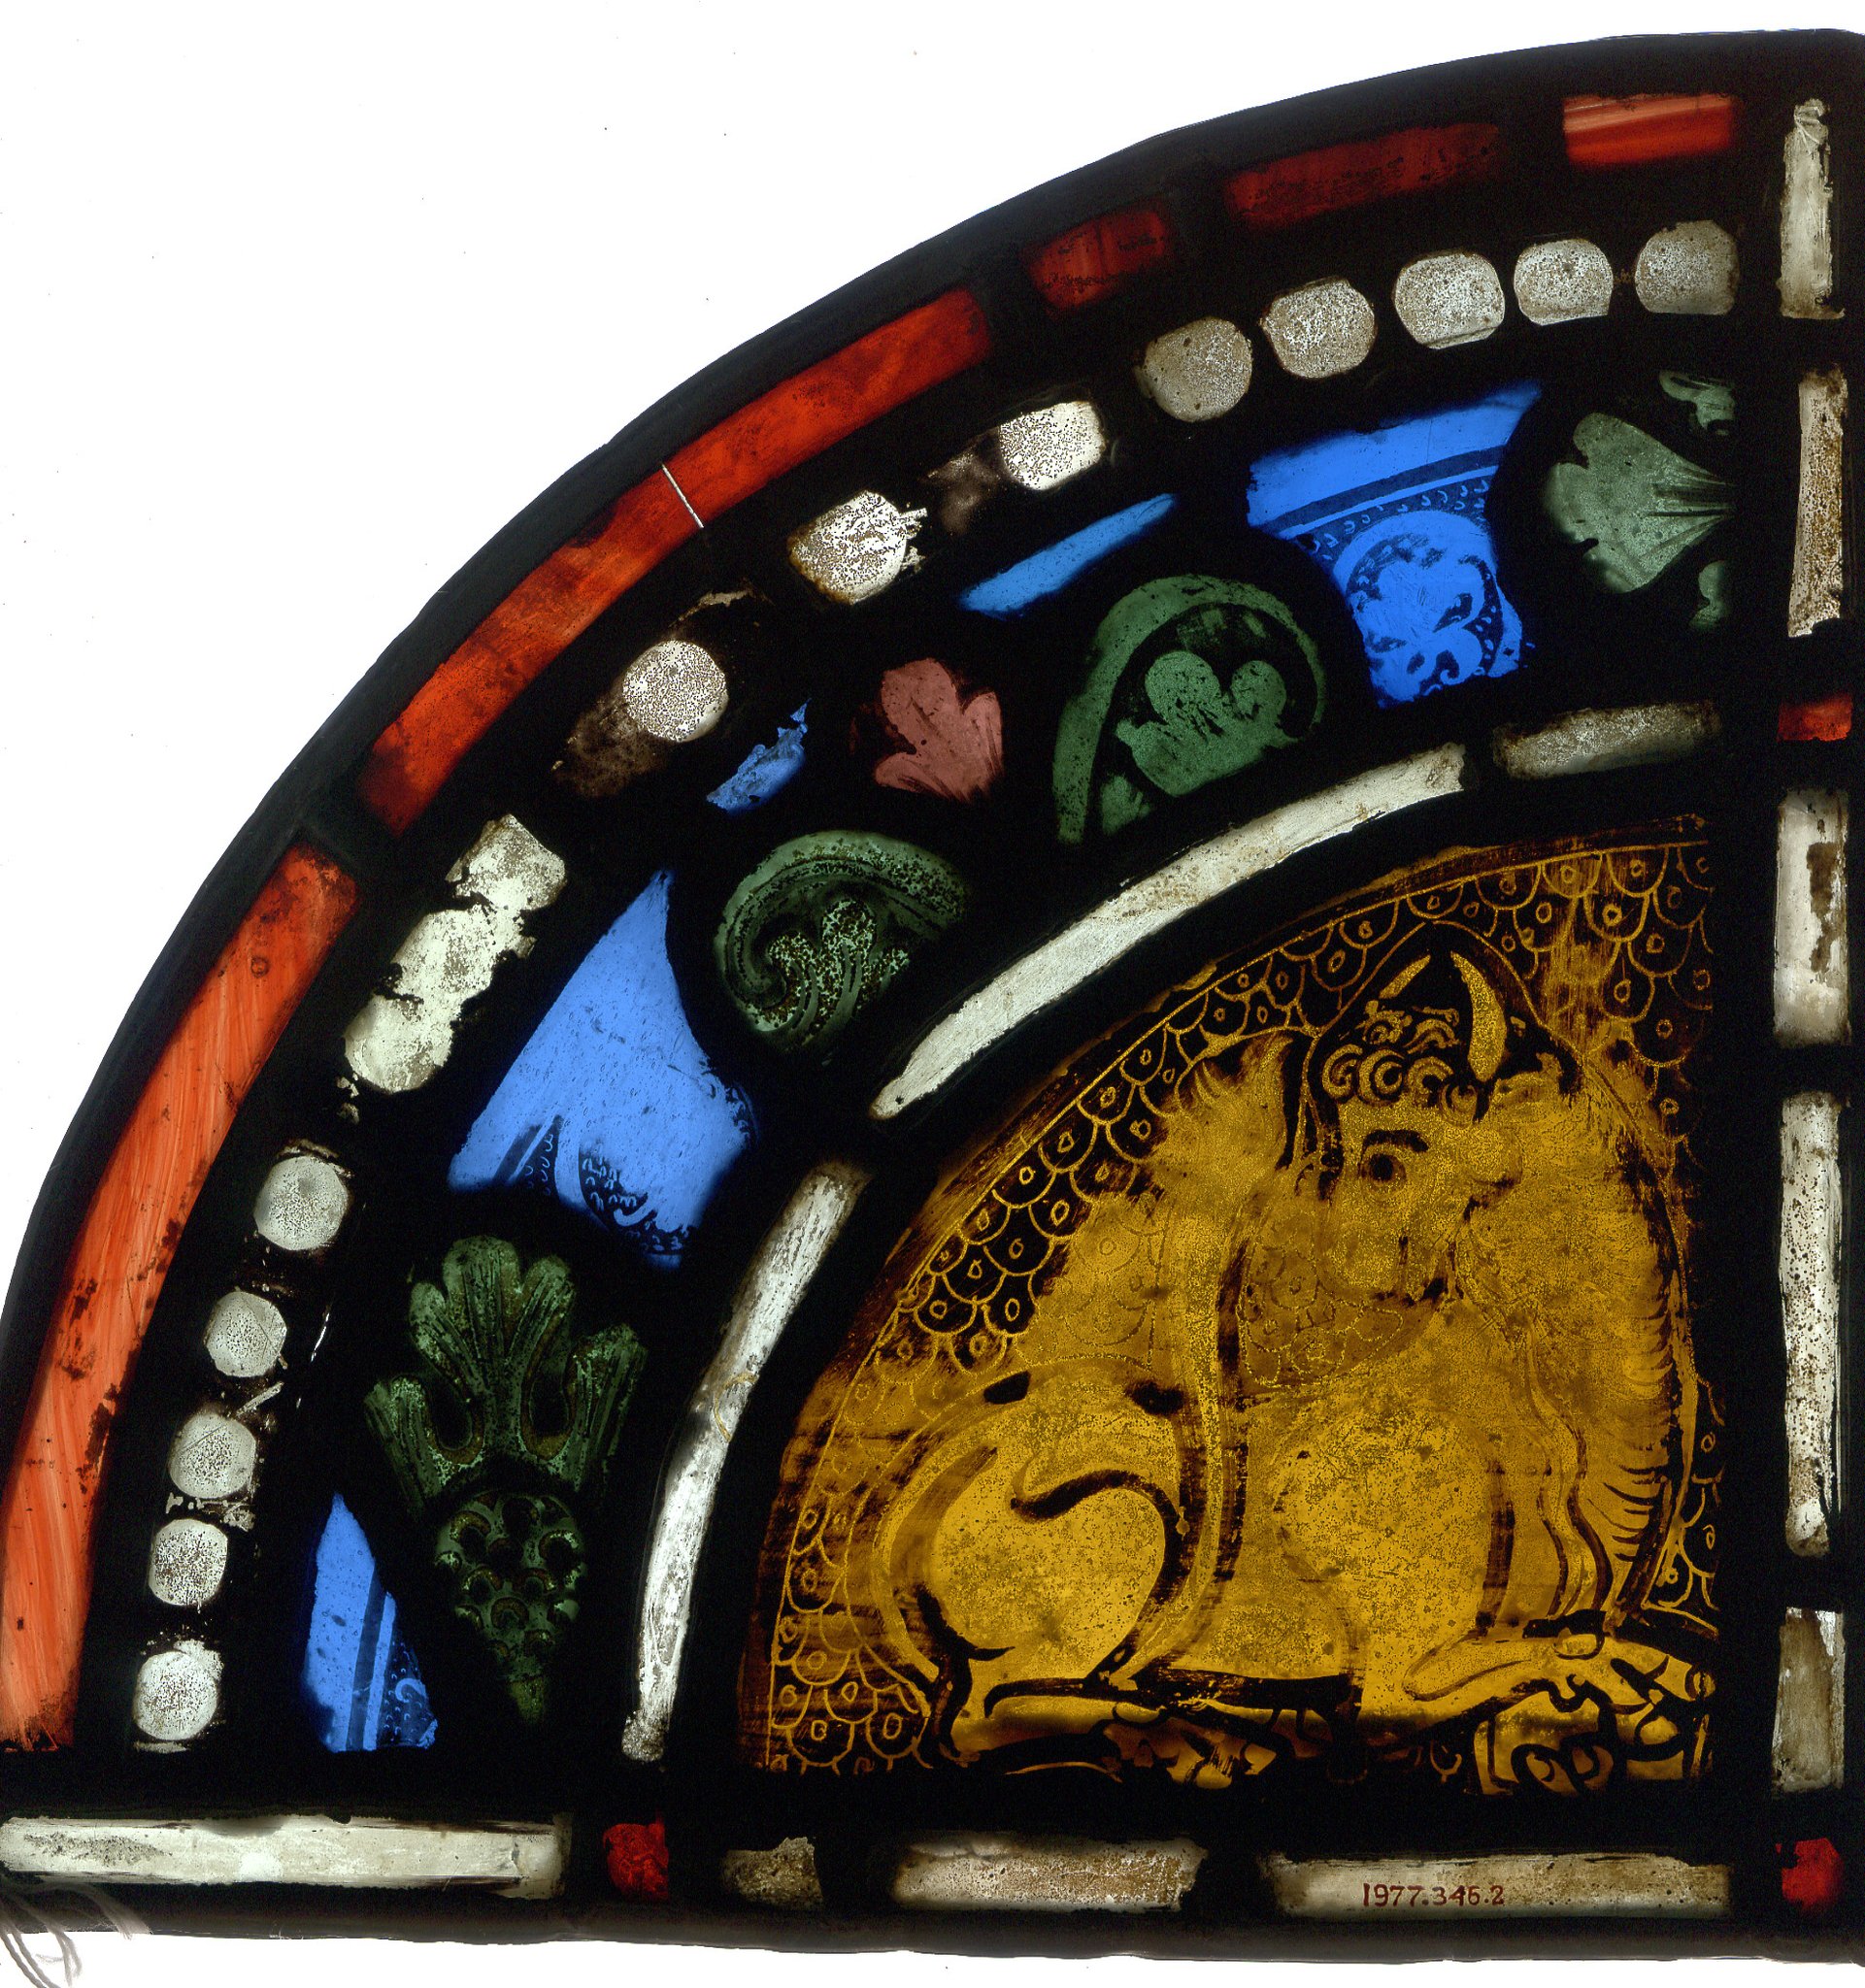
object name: fragment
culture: french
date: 1201-1300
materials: glass, lead, metal, paint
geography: france